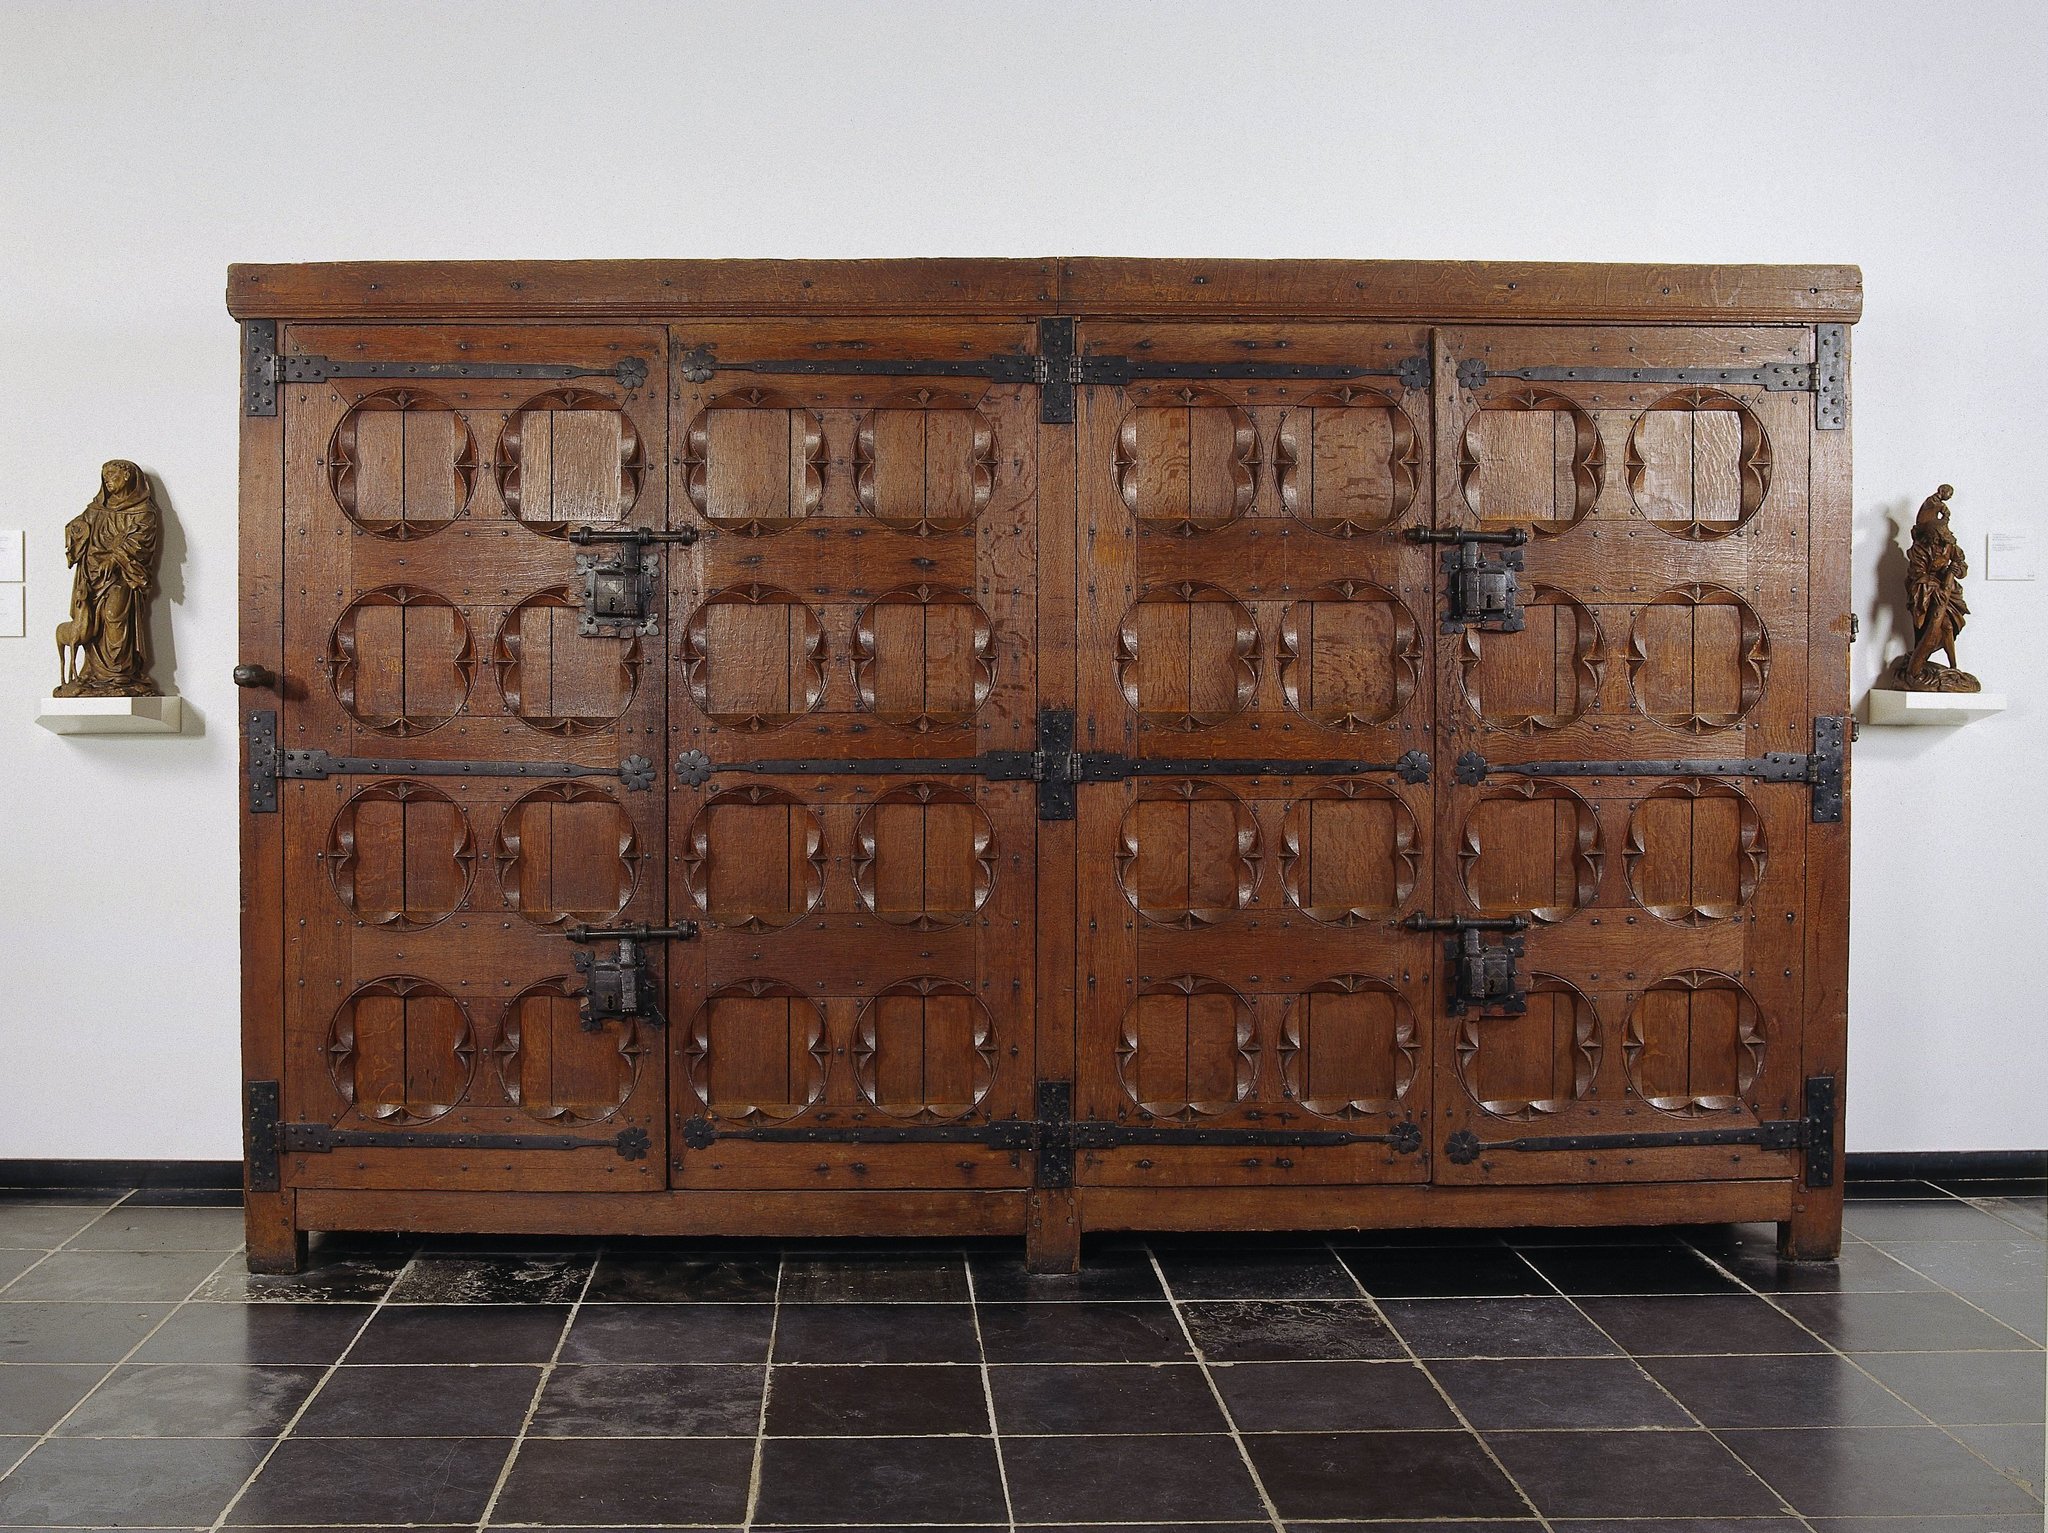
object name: furniture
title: Archiefkast domkapittel Utrecht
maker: Anonymous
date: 1500-1550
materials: iron, wood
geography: northern netherlands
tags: utrecht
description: Muniment cupboard, from the former Chapter of Utrecht Cathedral. Oak. Netherlands, c. 1500 - 1550.